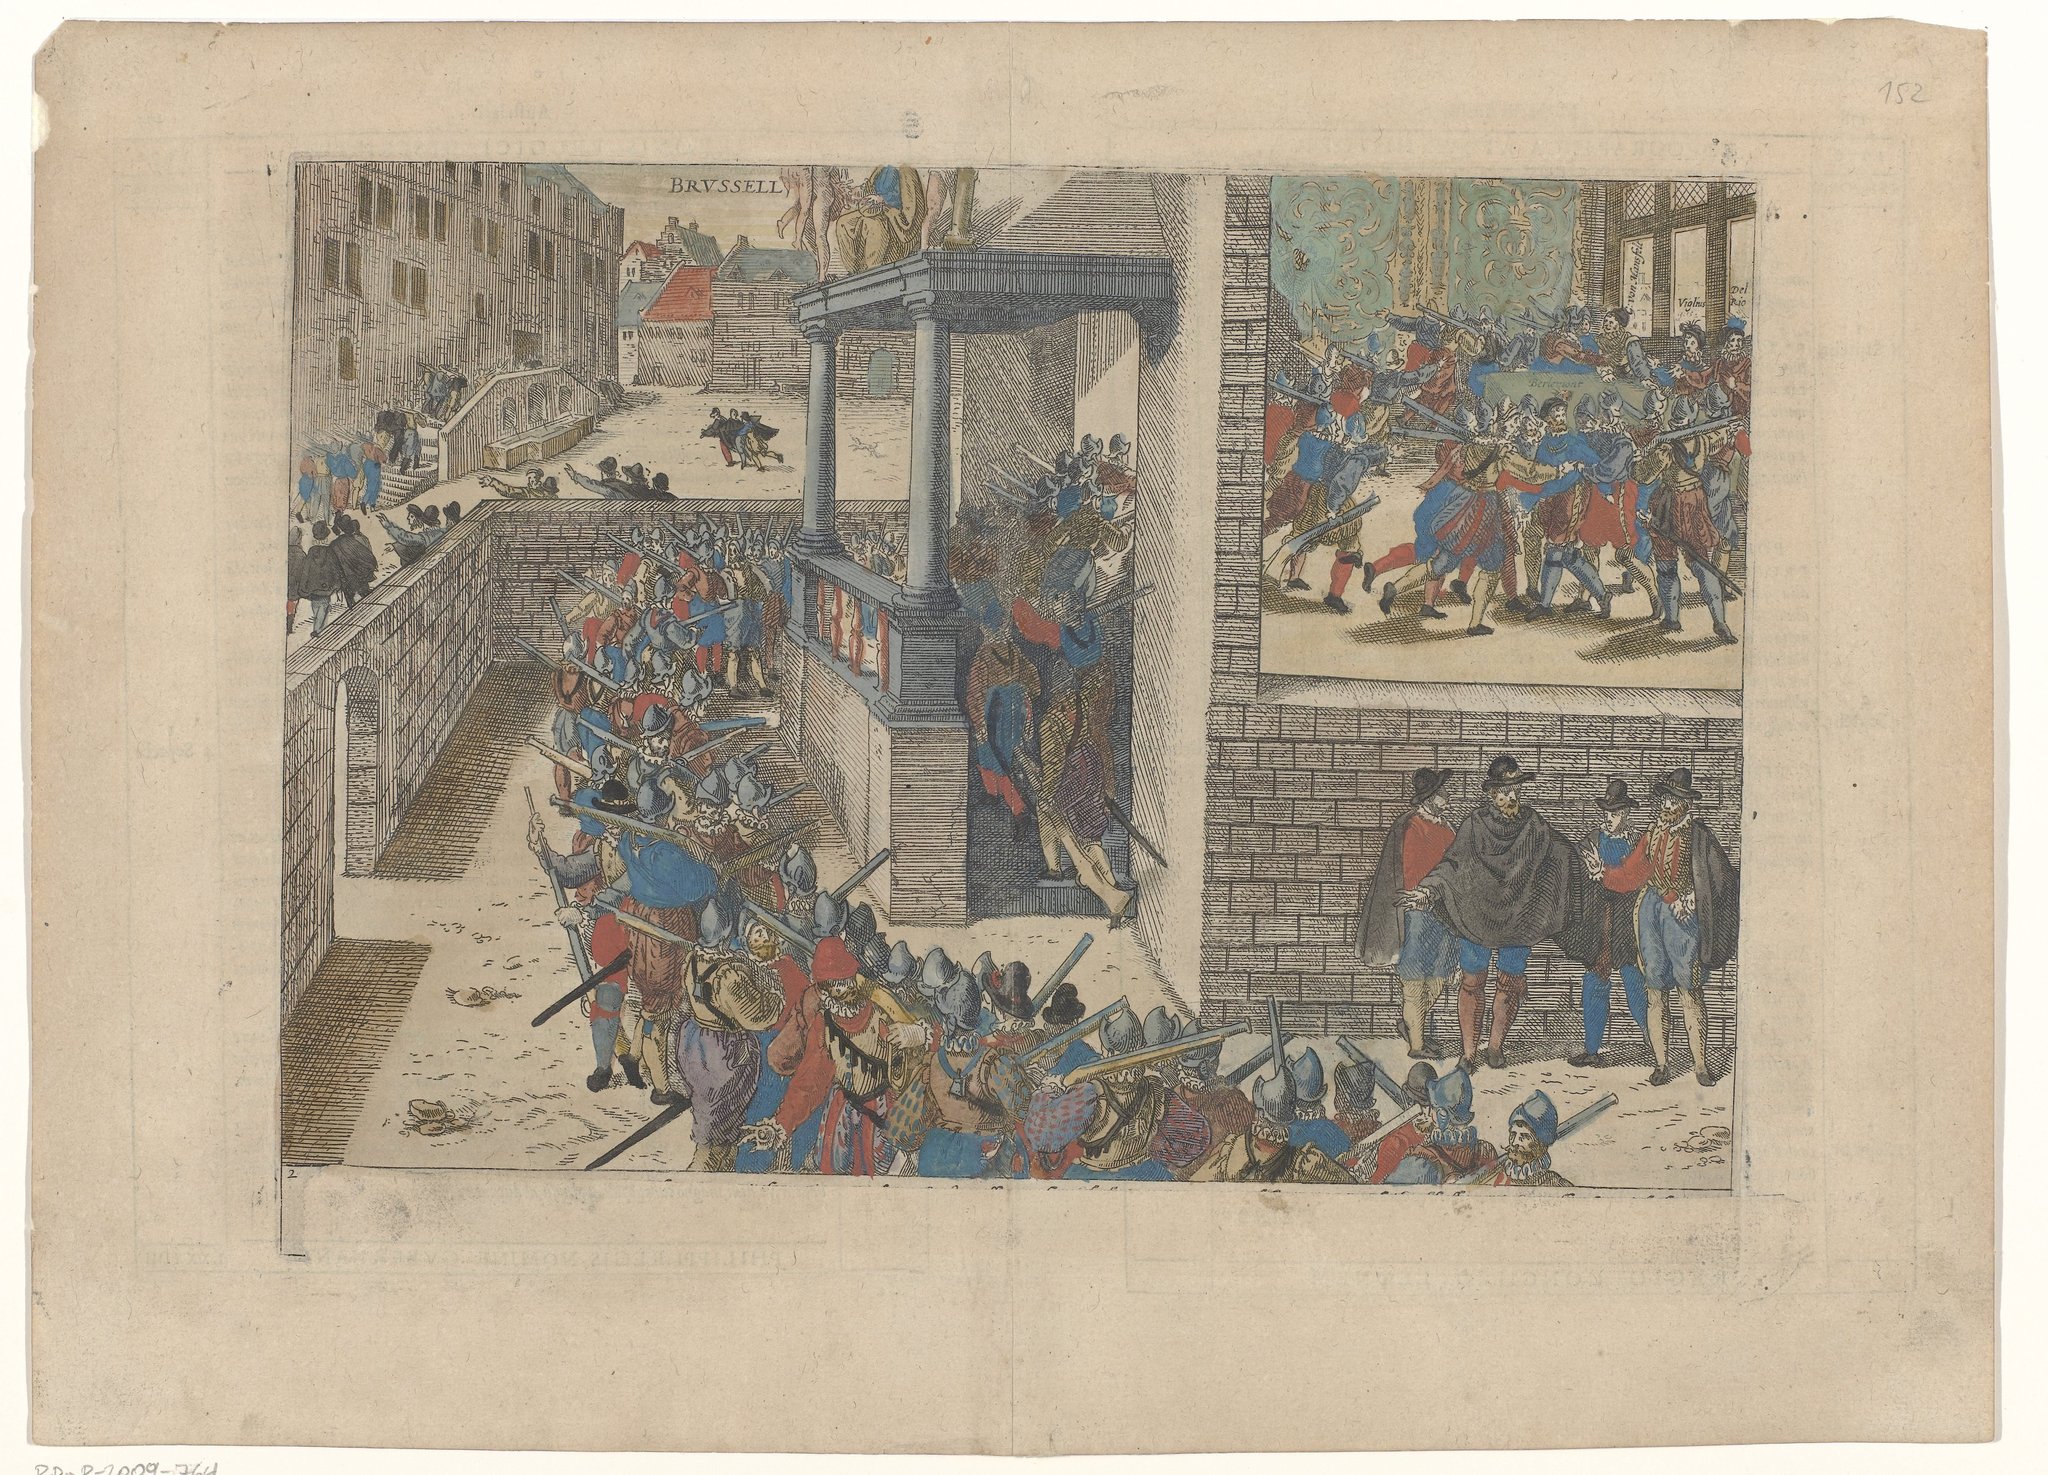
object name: print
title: De Spaansgezinde regering te Brussel afgezet, 1576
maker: frans hogenberg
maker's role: print maker, publisher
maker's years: 1538-1590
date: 1588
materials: paper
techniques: etching, hand coloring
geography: cologne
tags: charles de berlaymont, bruges, brussels, clergyman, criminal law; punishment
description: De leden van de Spaansgezinde Raad van State worden in Brussel gevangen genomen, 5 september 1576. Soldaten overvallen het gebouw waar de Raad bijeen was. Boven worden Van Mansfeld, Berlaymont, Viglius en Del Rio gearresteerd. Gedrukt met een cache over het onderschrift.